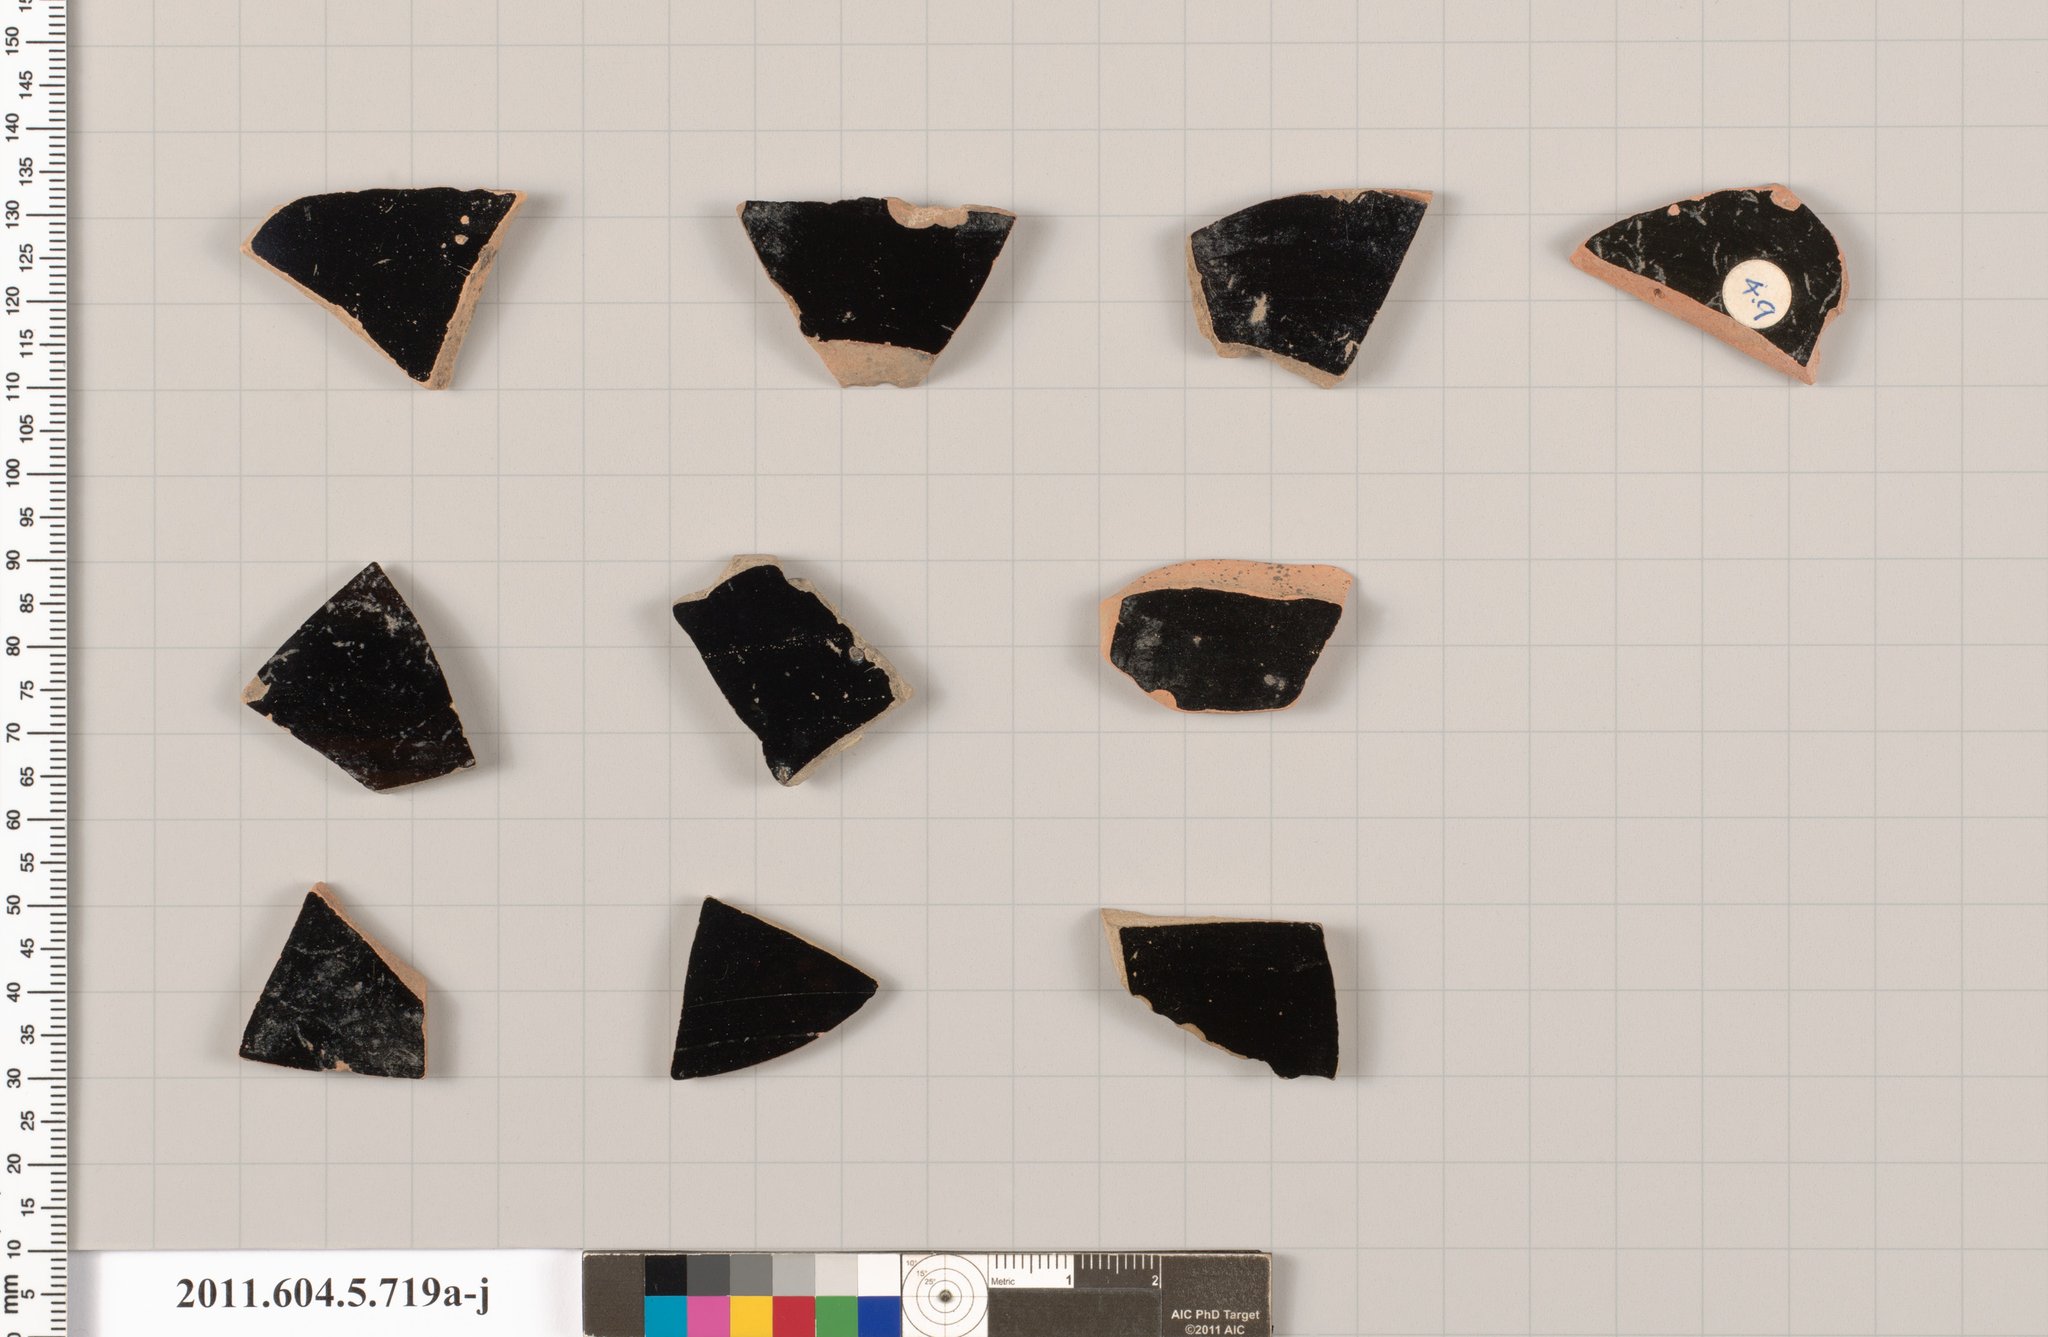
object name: kylix fragment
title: Terracotta fragments of kylikes (drinking cups)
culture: greek, attic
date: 600-401 BCE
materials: terracotta